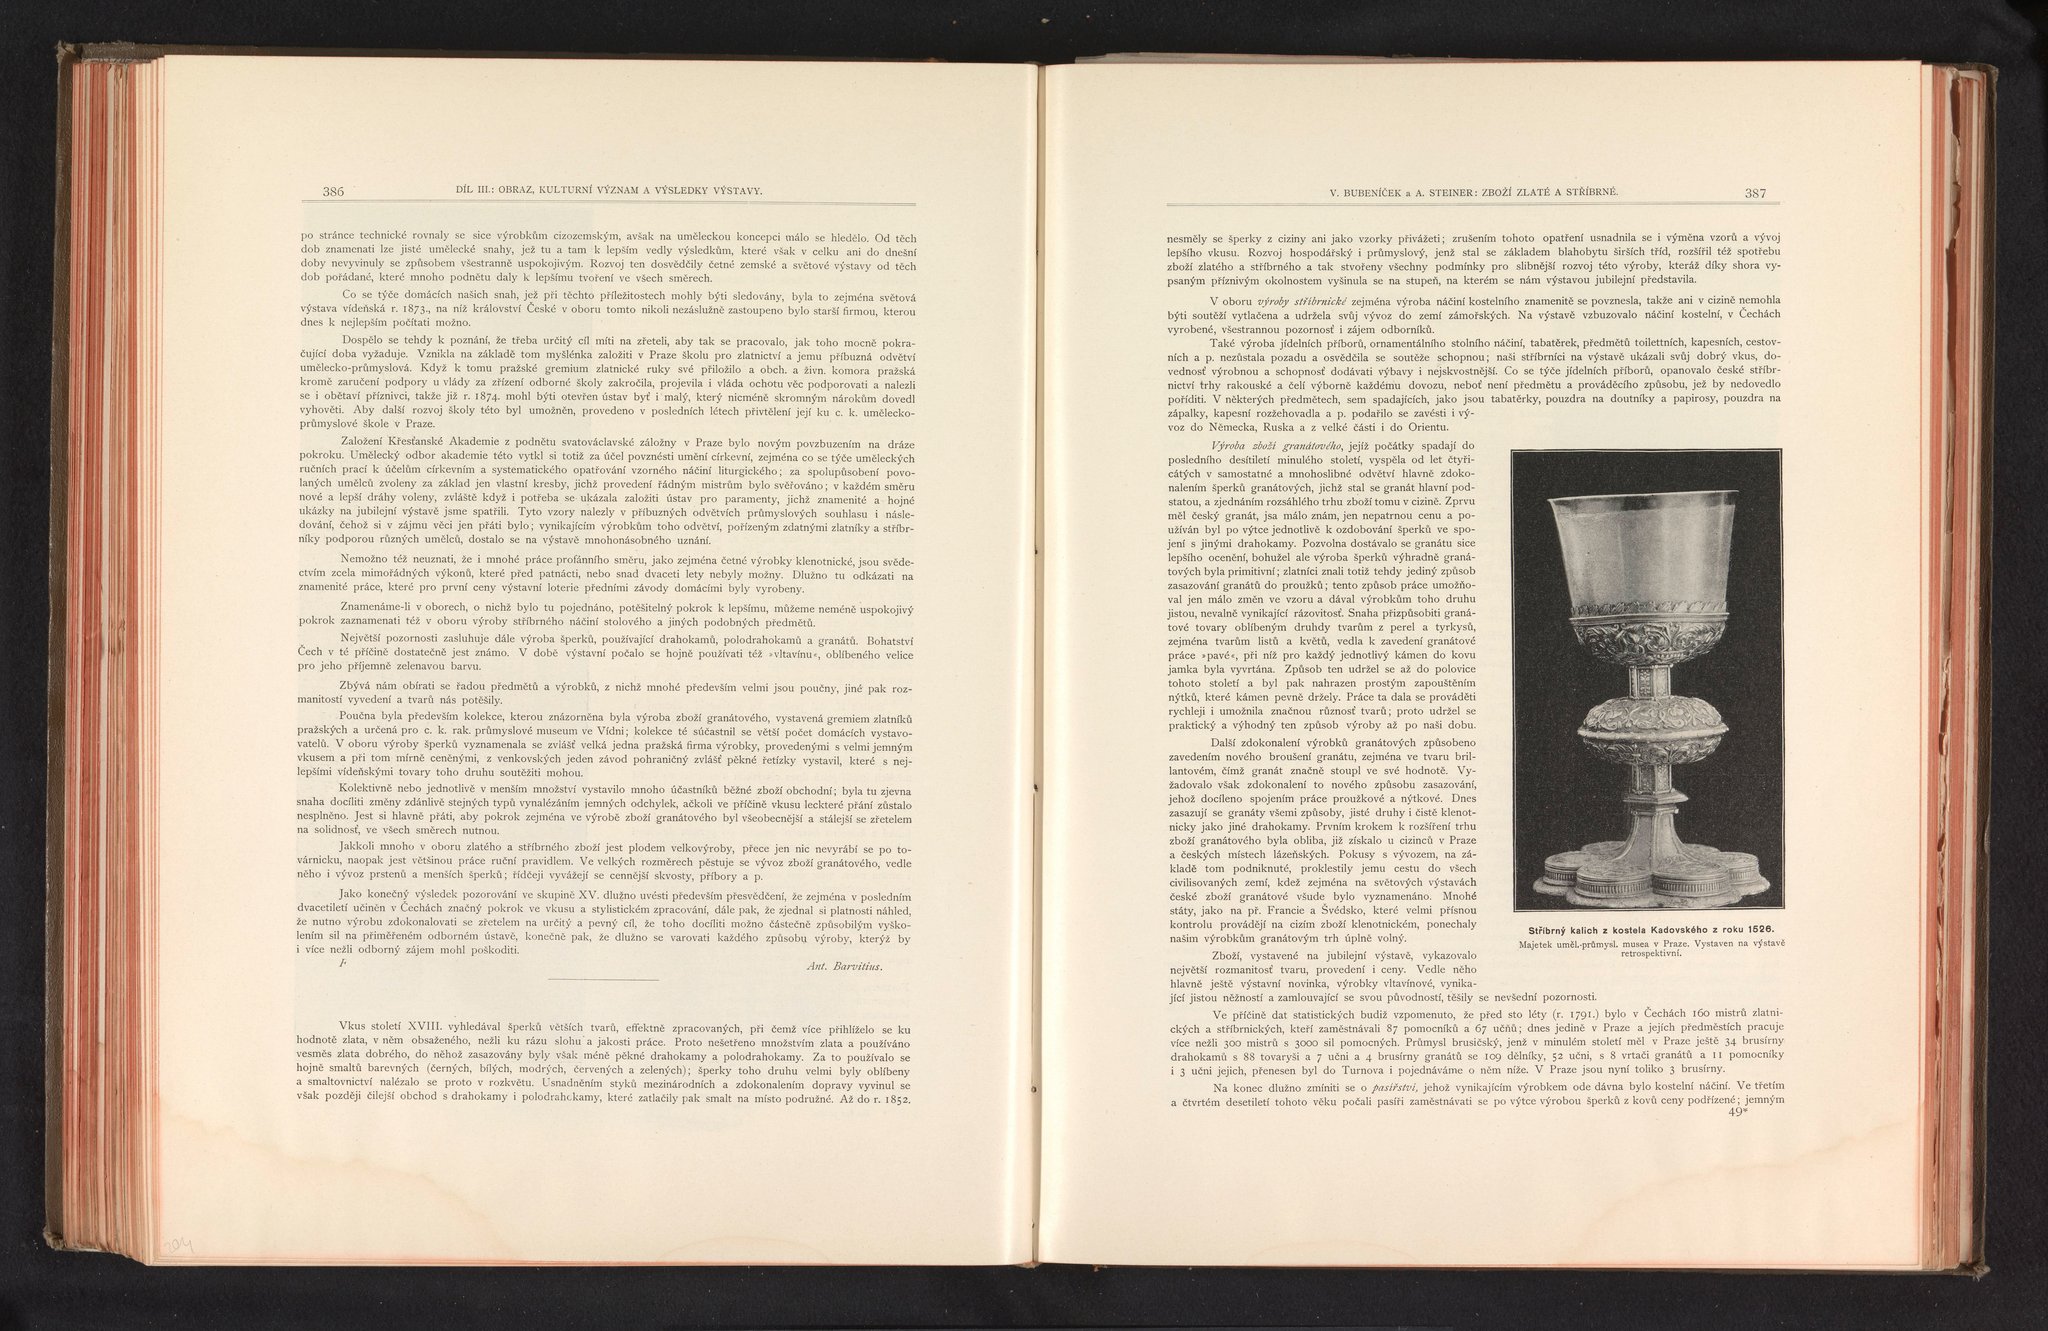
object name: photomechanical print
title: Stribrný kalich z kostela Kadovského z roku 1526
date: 1890-1895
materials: paper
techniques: autotype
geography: prague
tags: chalice